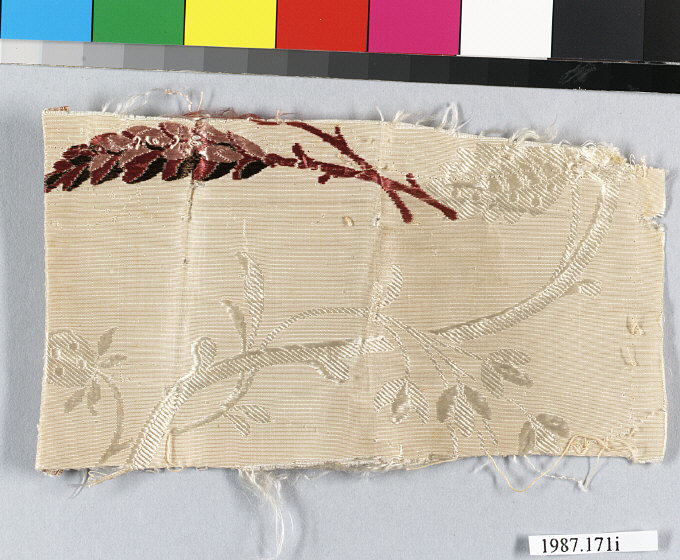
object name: piece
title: Piece (?)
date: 1750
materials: silk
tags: leaves